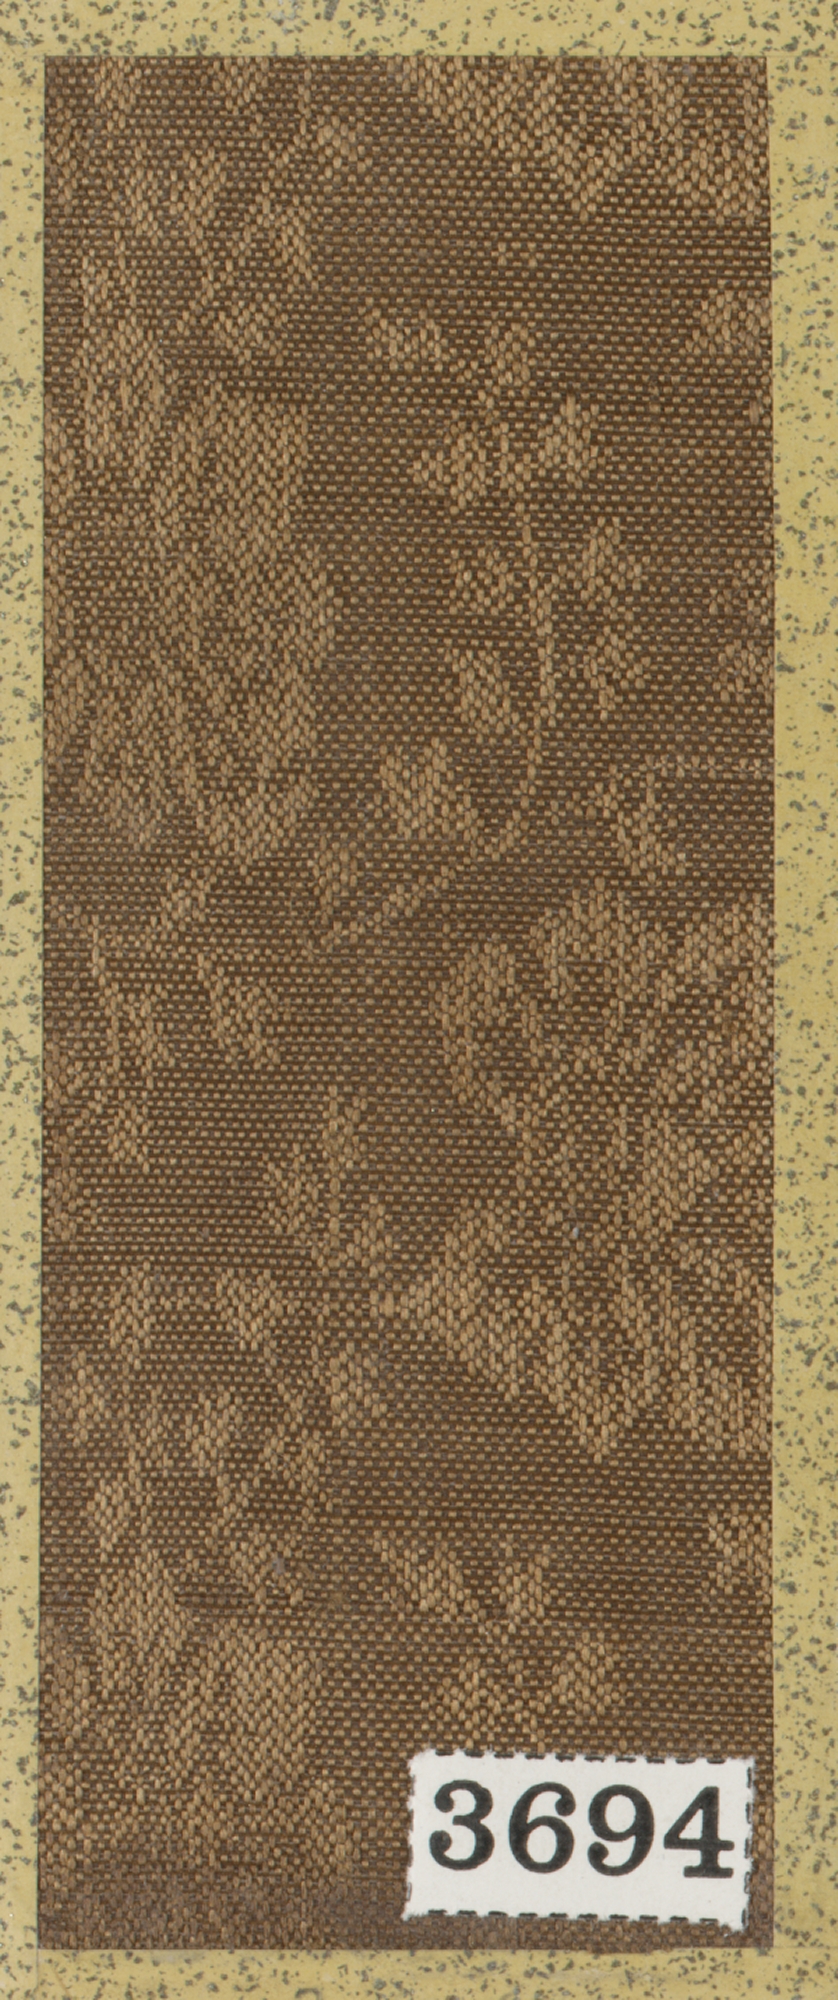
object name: sample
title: Textile Sample from Sample Book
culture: japanese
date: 1801-1900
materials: silk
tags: plants